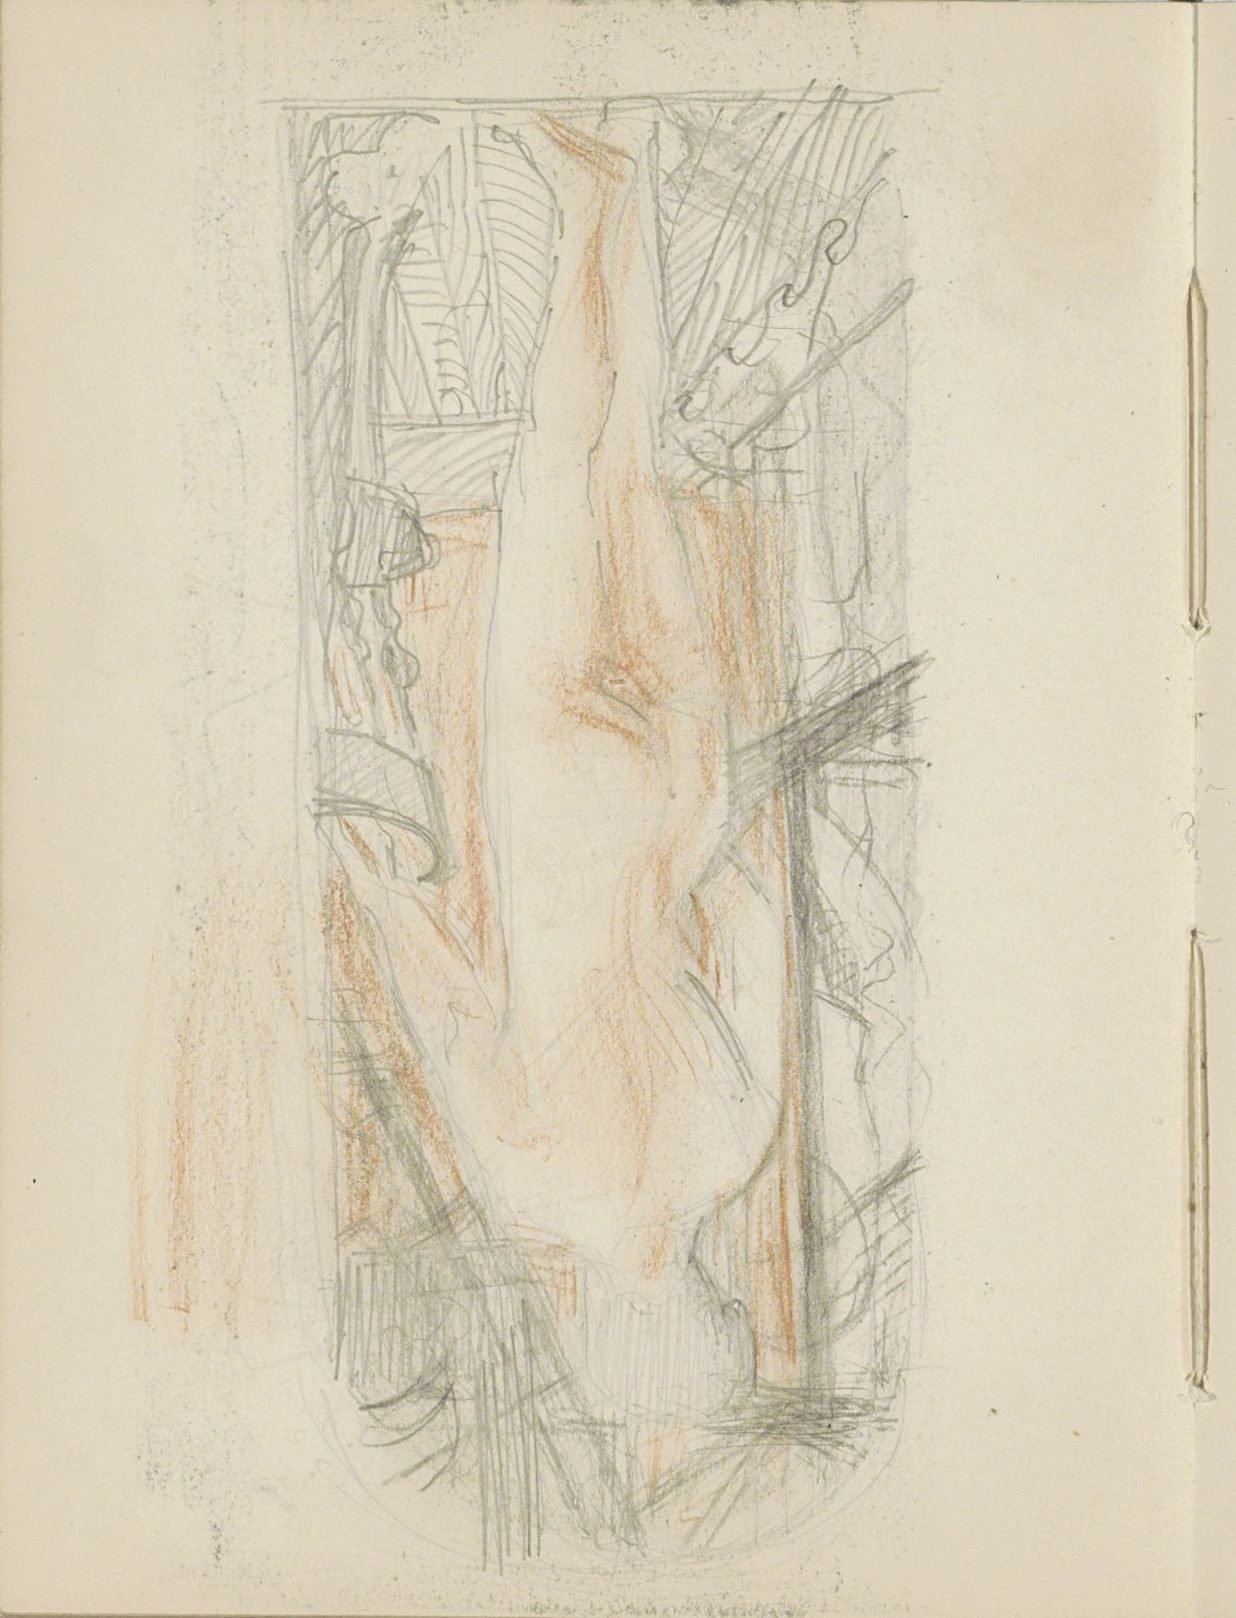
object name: sketchbook leaf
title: Achterzijde van een staande naakte vrouw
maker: reijer stolk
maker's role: draughtsman, print maker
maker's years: 1896-1945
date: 1906-1945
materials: chalk, paper, pencil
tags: standing figure - aa - female human figure (+ nude human being)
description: De vrouw lijkt in een nis te staan naast een tafel. Blad 37 verso uit een schetsboek met 69 bladen.